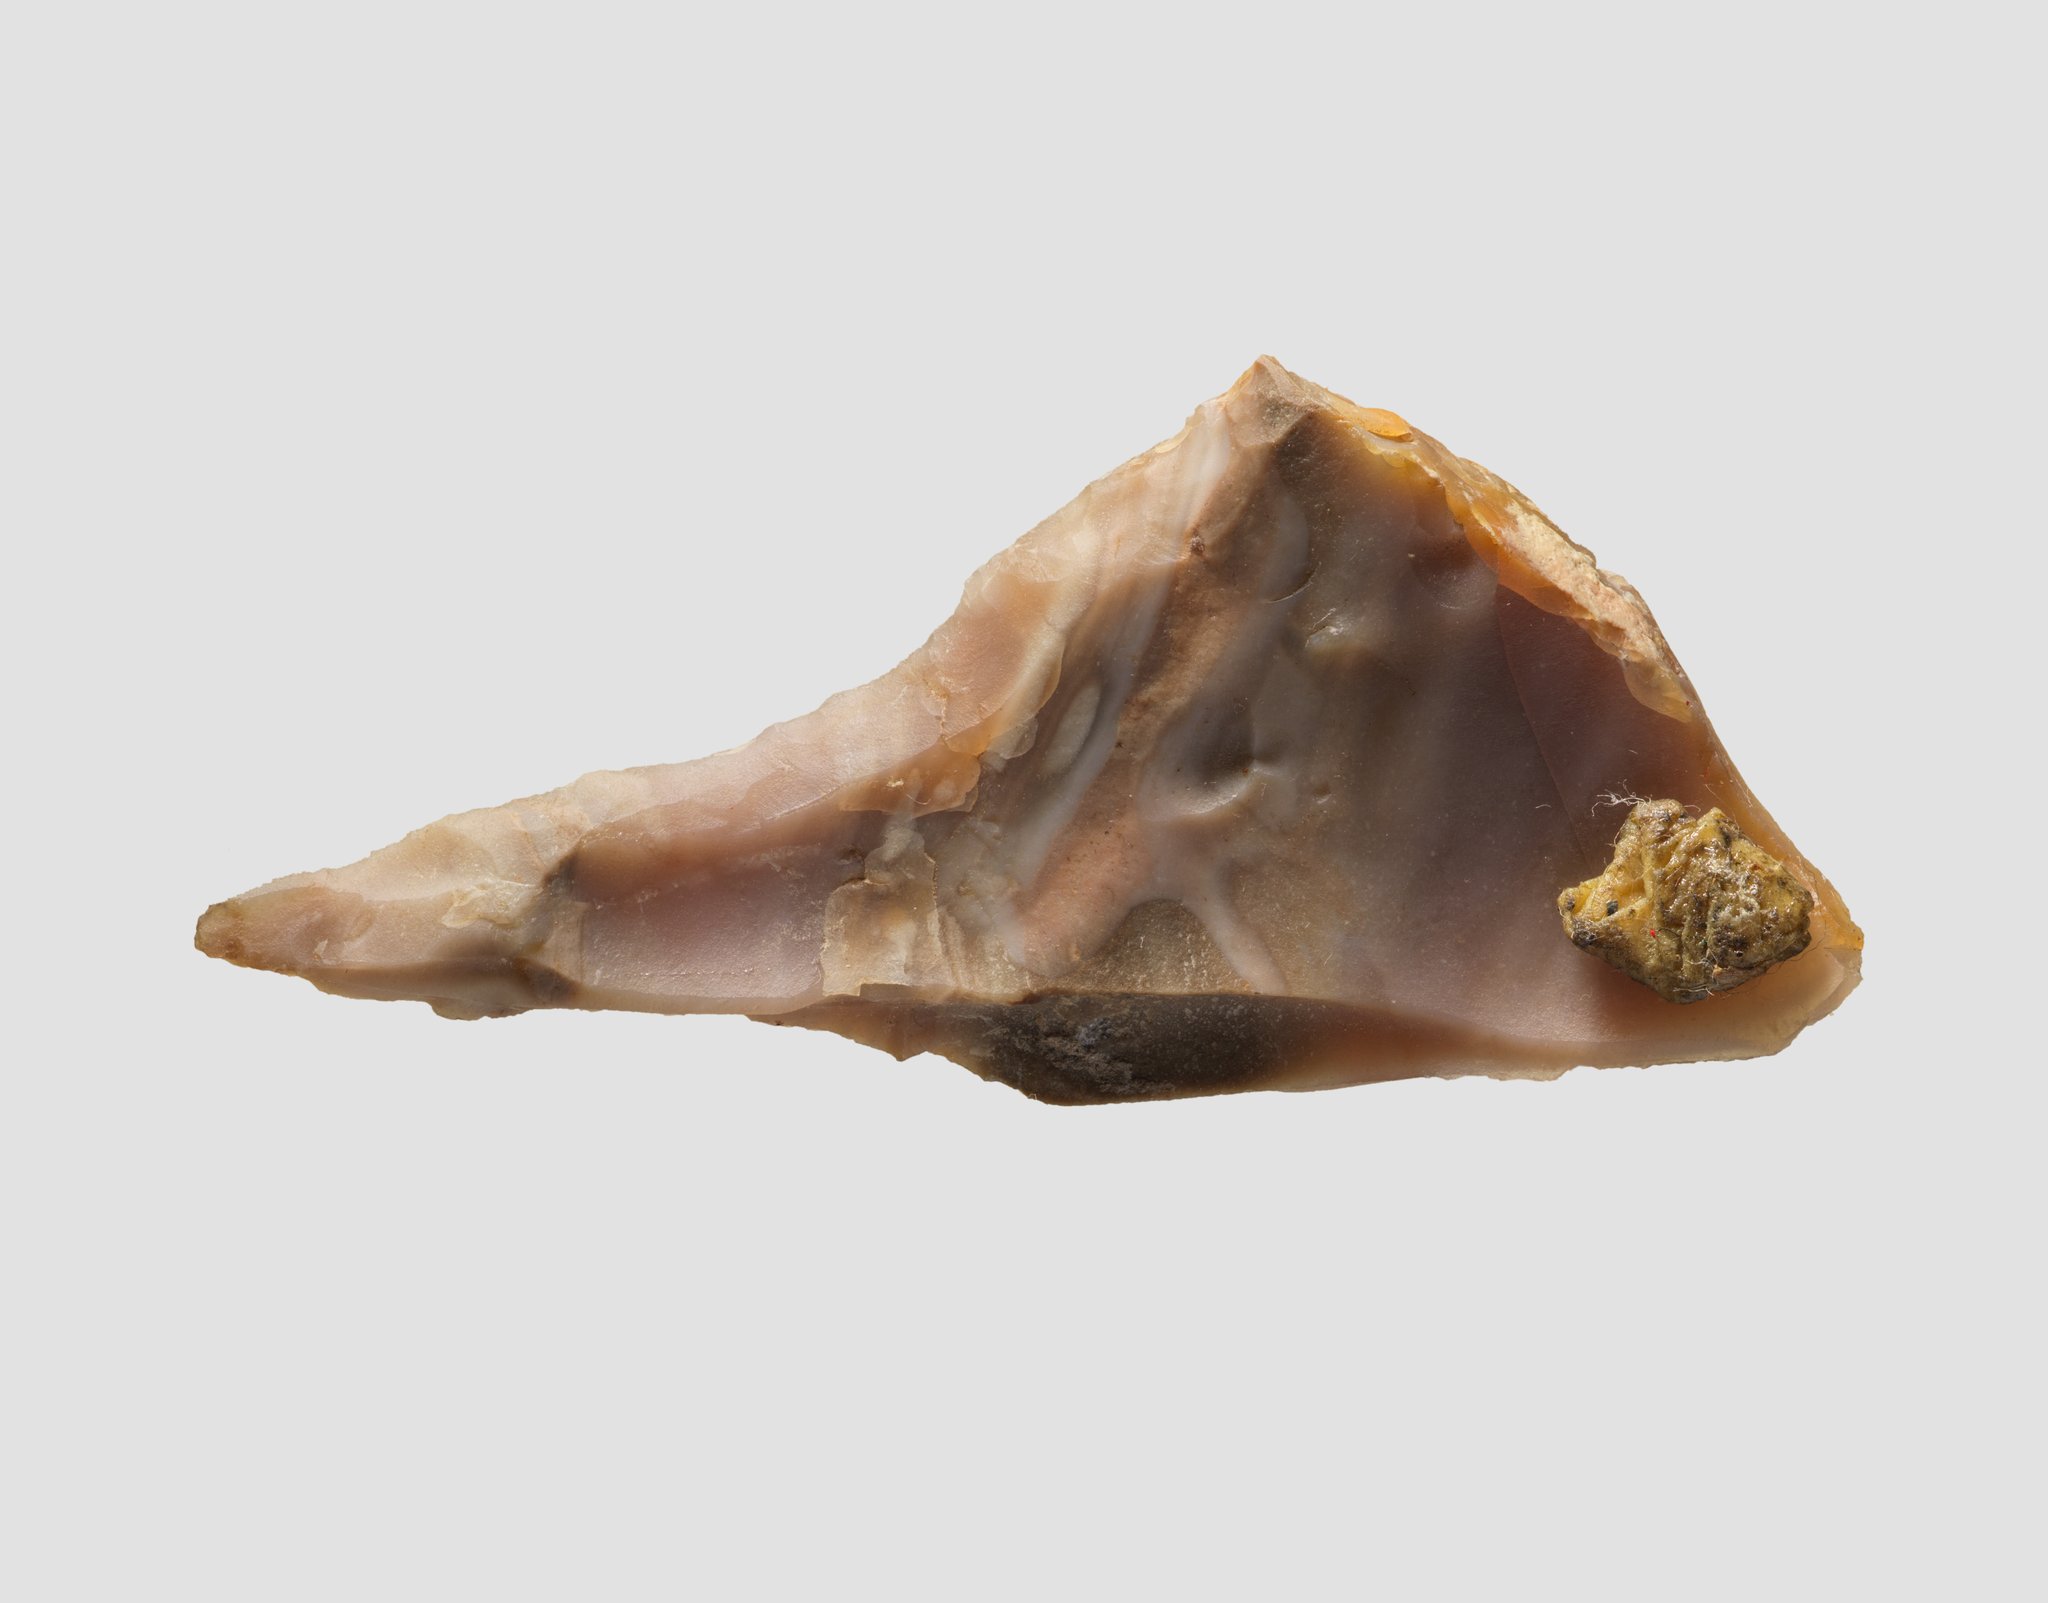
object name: awl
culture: ghassulian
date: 4600-3600 BCE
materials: stone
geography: levant